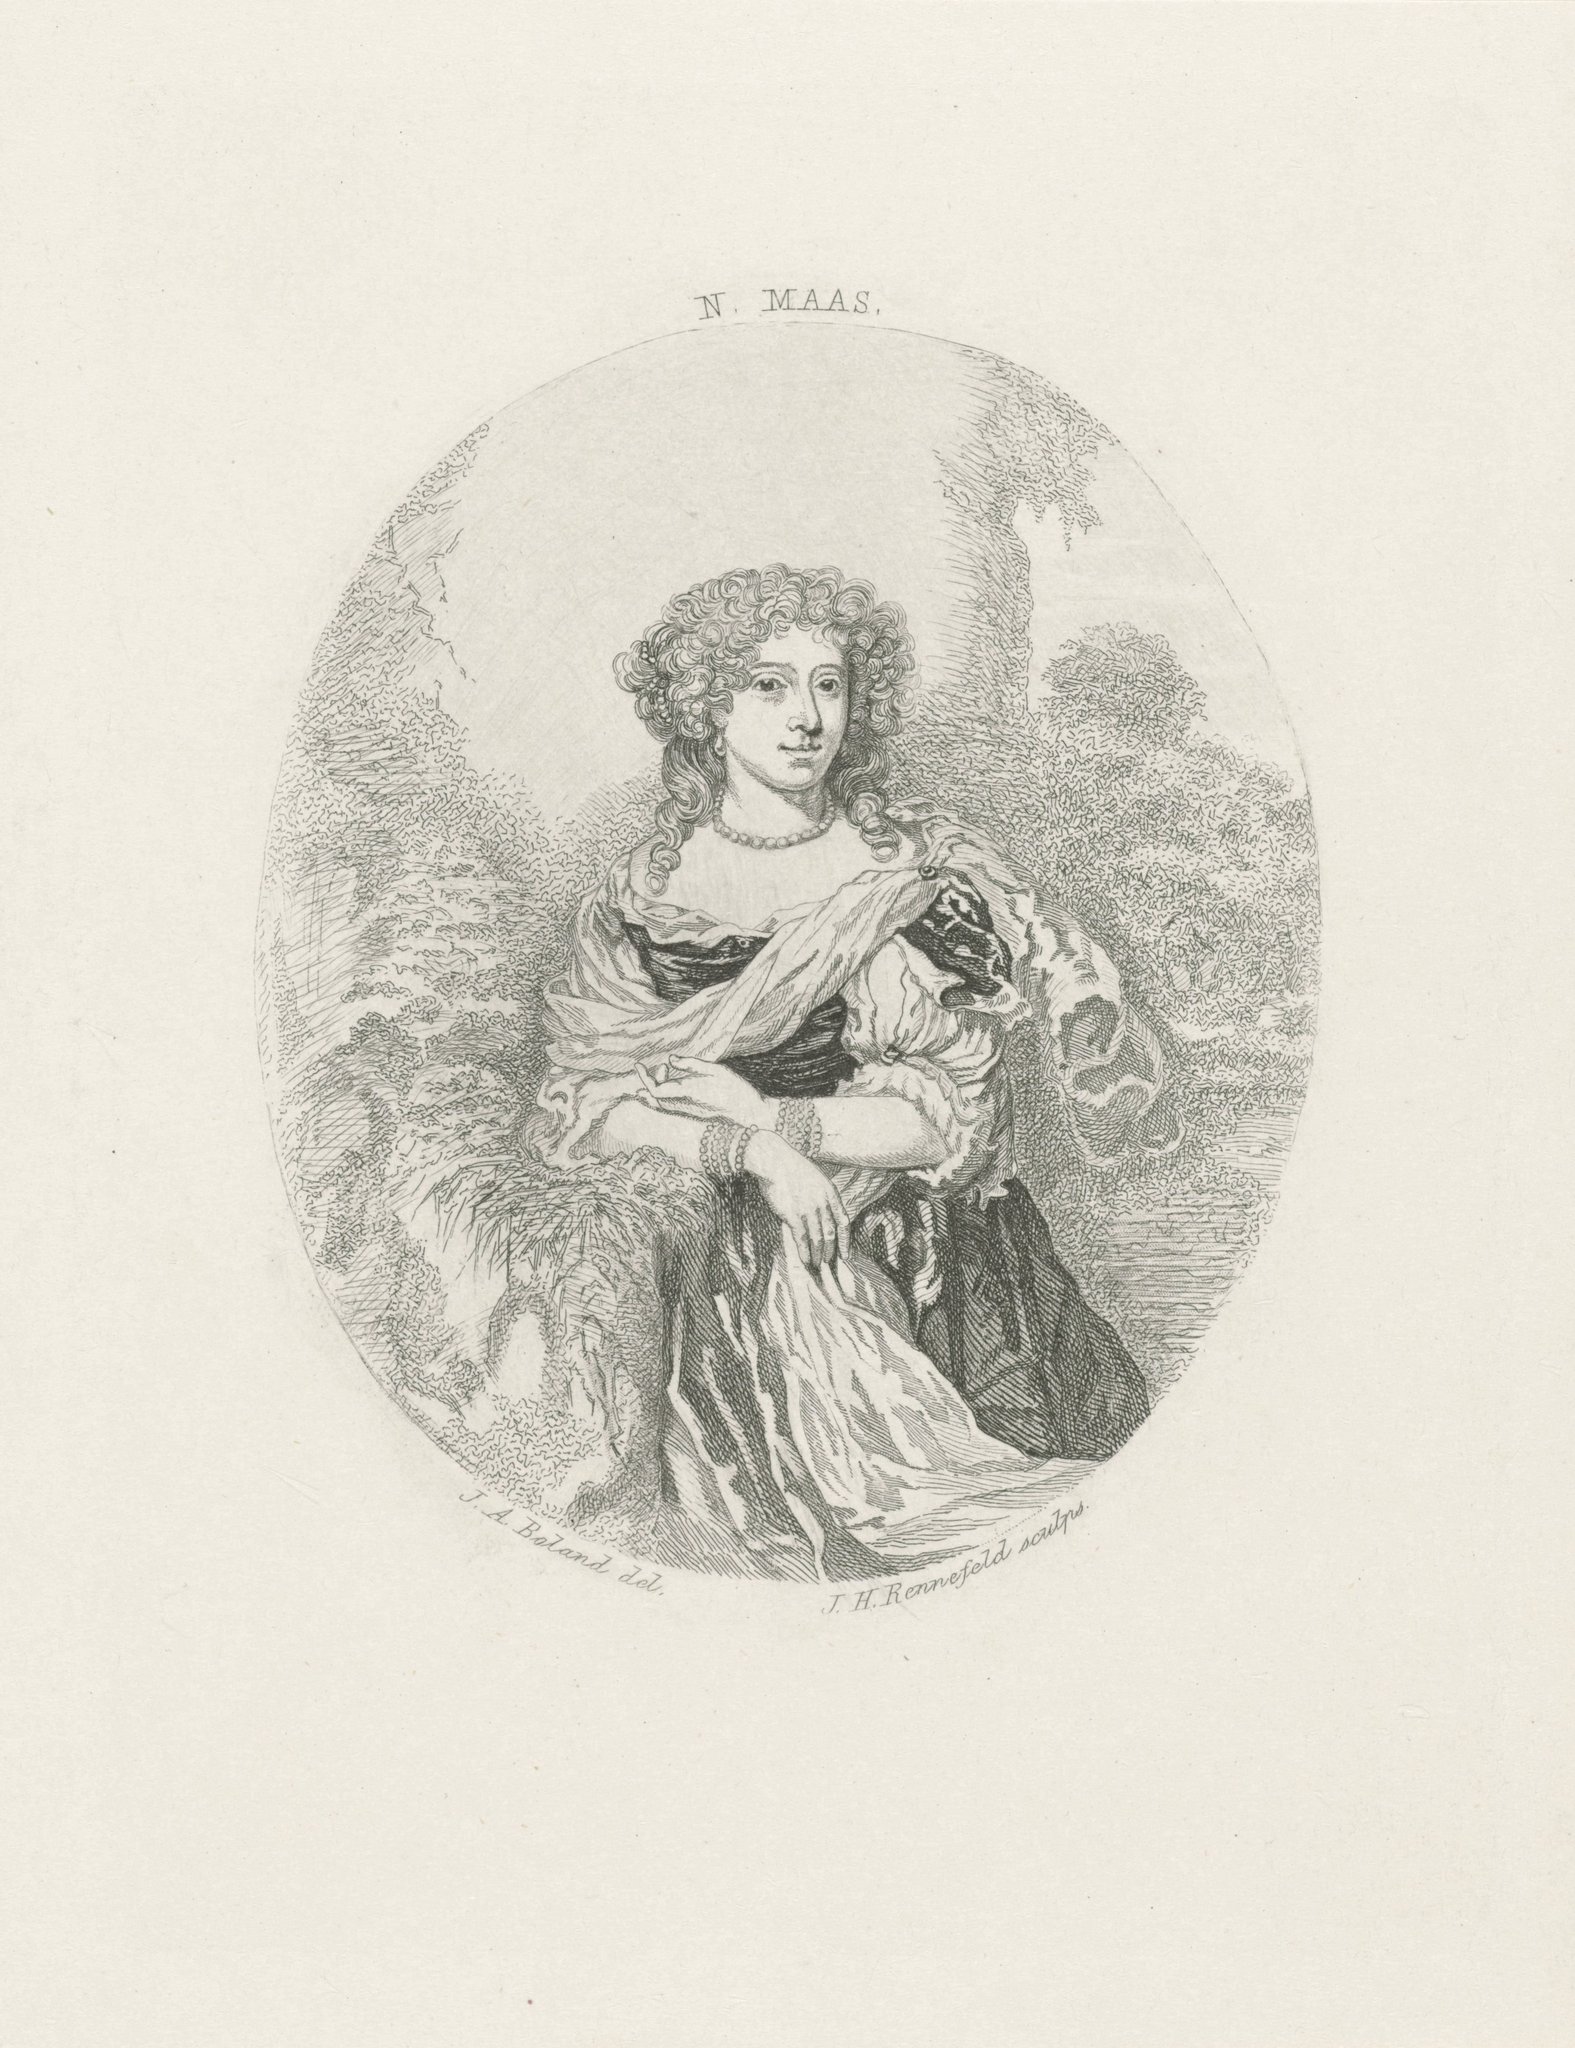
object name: print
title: Portret van een vrouw in de buitenlucht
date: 1845-1877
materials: paper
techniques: etching, roulette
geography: amsterdam